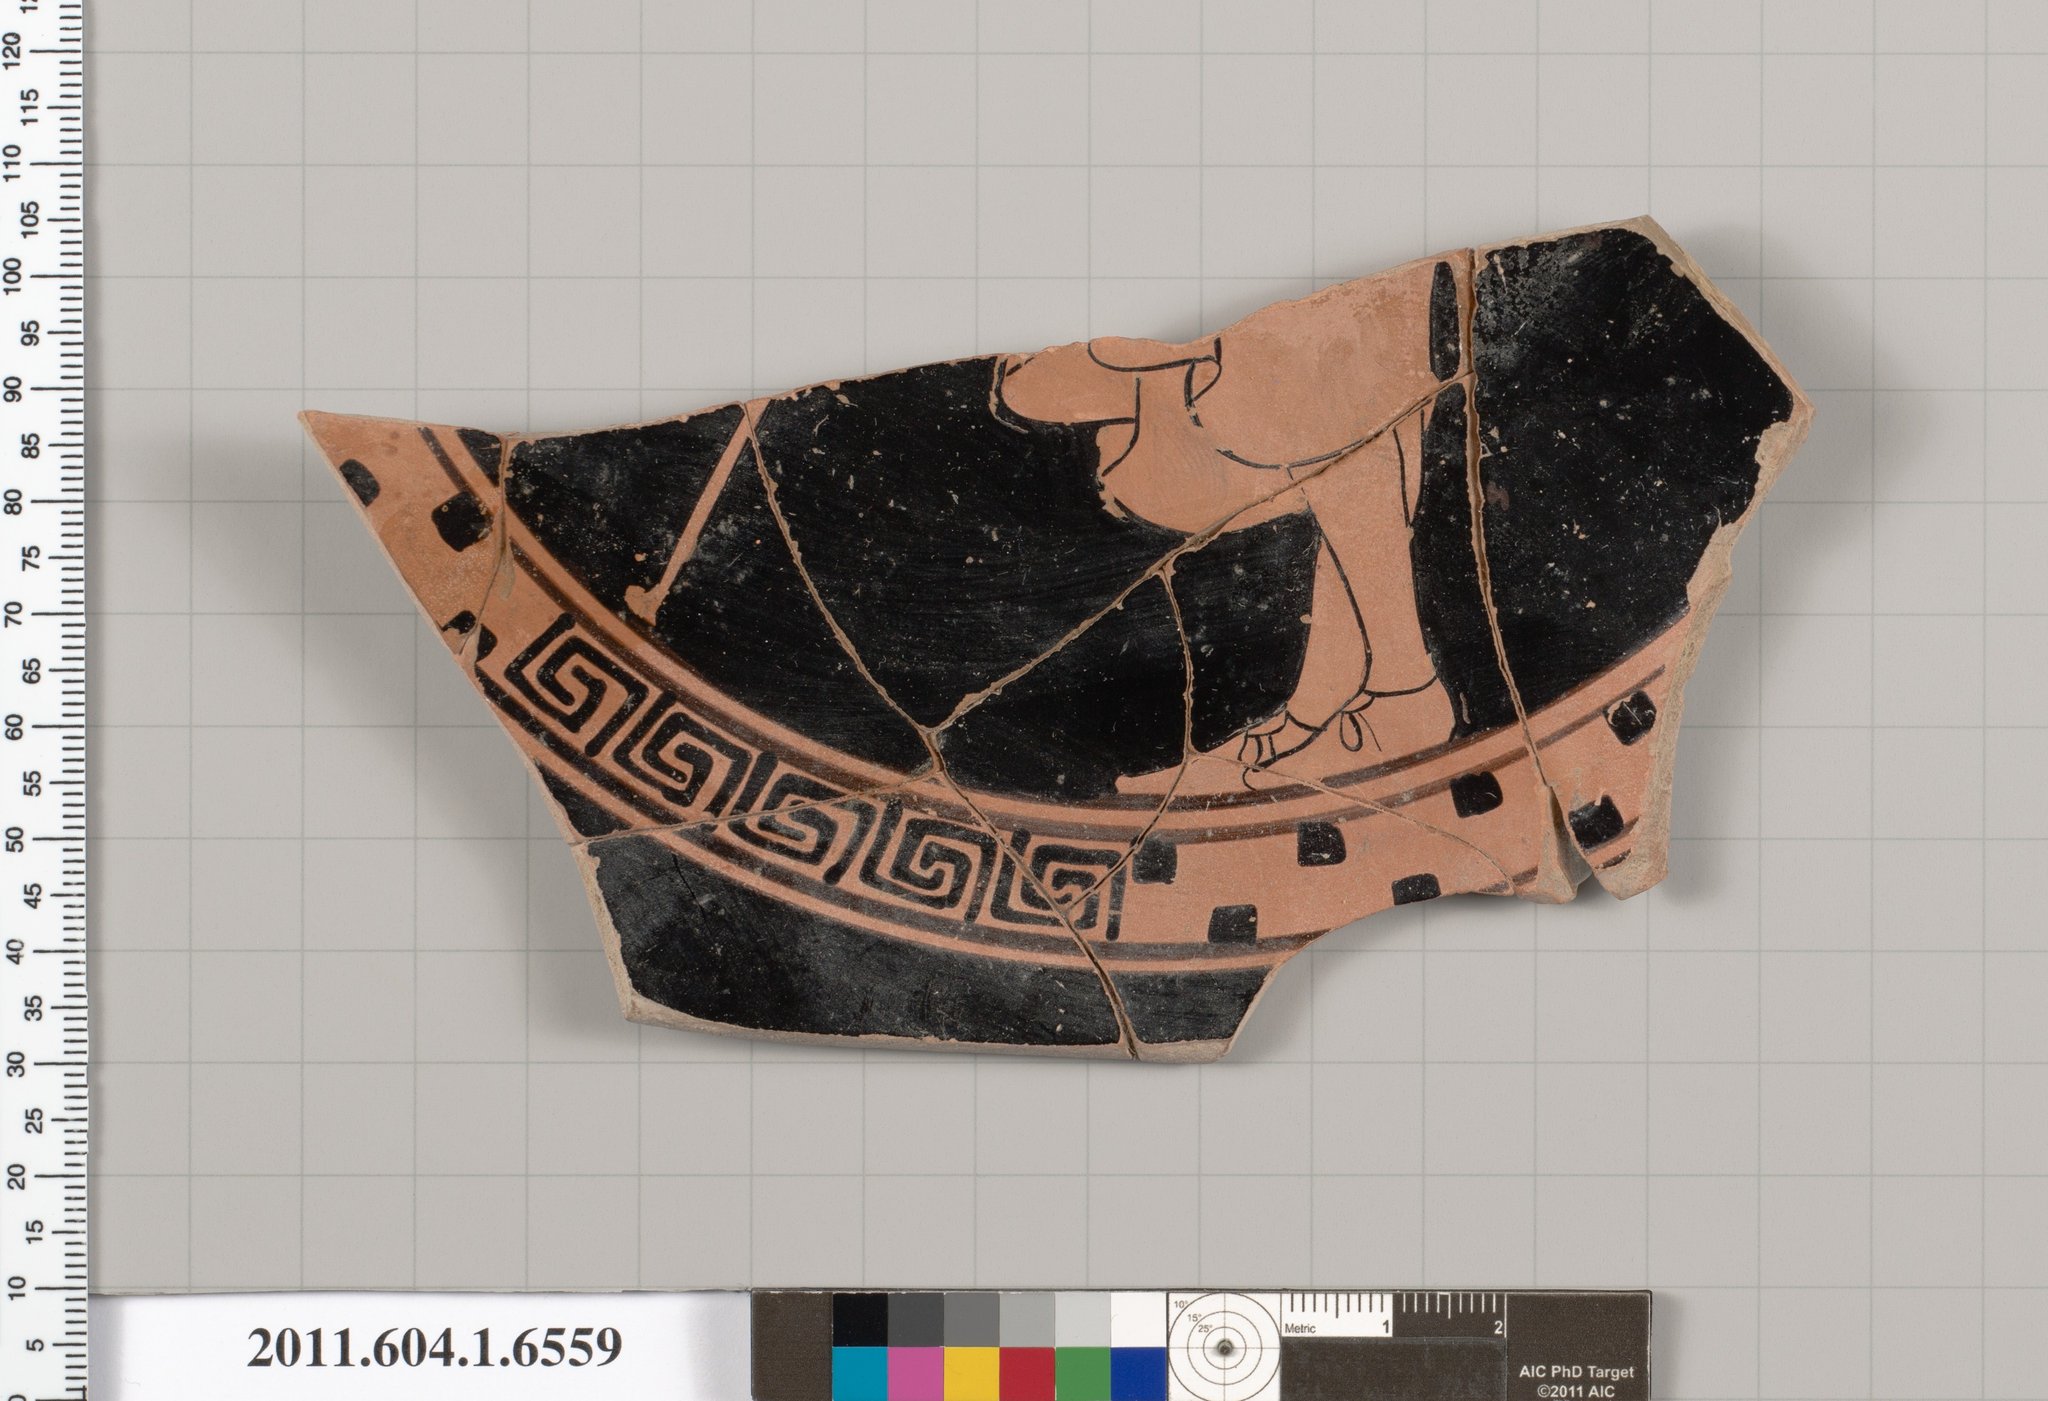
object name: kylix fragment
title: Terracotta fragment of a kylix (drinking cup)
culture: greek, attic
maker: colmar painter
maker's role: artist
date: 490-480 BCE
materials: terracotta